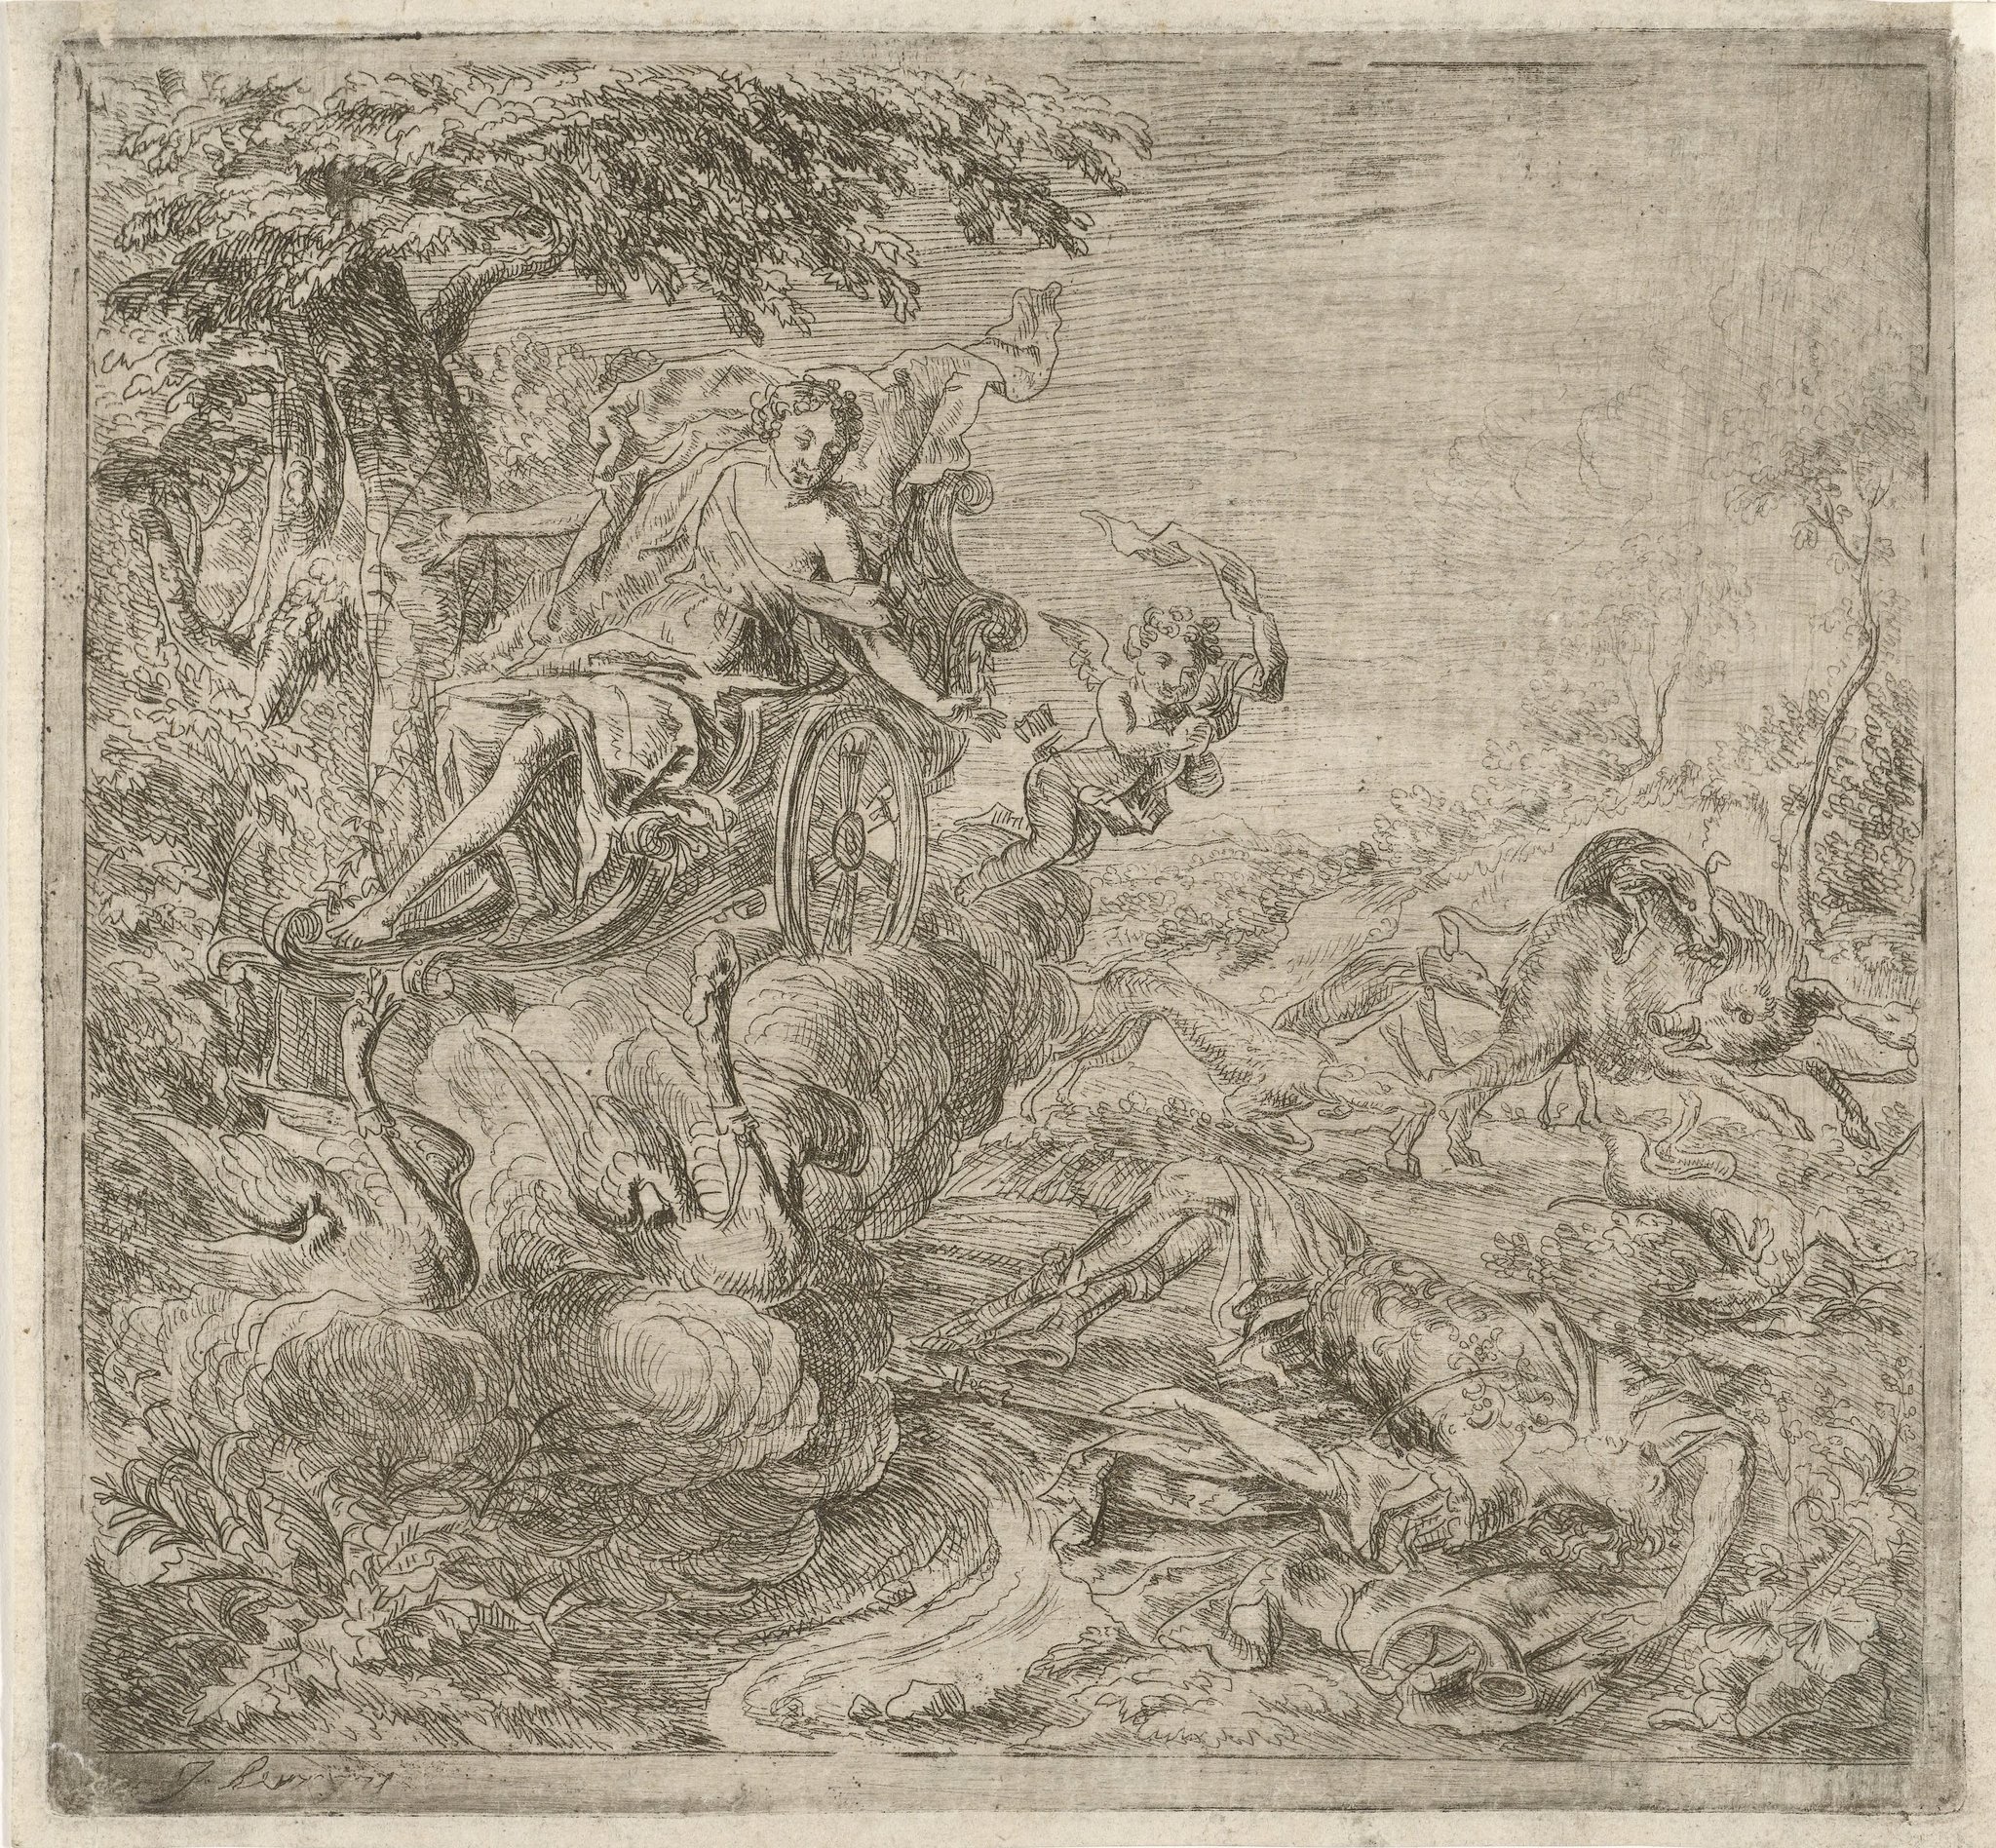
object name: print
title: Venus vindt de dode Adonis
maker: jacob herreyns (i)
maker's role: painter, print maker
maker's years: 1643-1732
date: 1671-1732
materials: paper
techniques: etching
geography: antwerp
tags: venus mourning adonis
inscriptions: collector's mark: Lugt 514, collector's mark: Lugt 2165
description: De door zwanen getrokken wagen met Venus en Amor daalt neer bij Adonis, die is gedood door het wilde zwijn, dat op de achtergrond wordt verscheurd door honden. Naast Adonis zijn jachthoorn en speer.